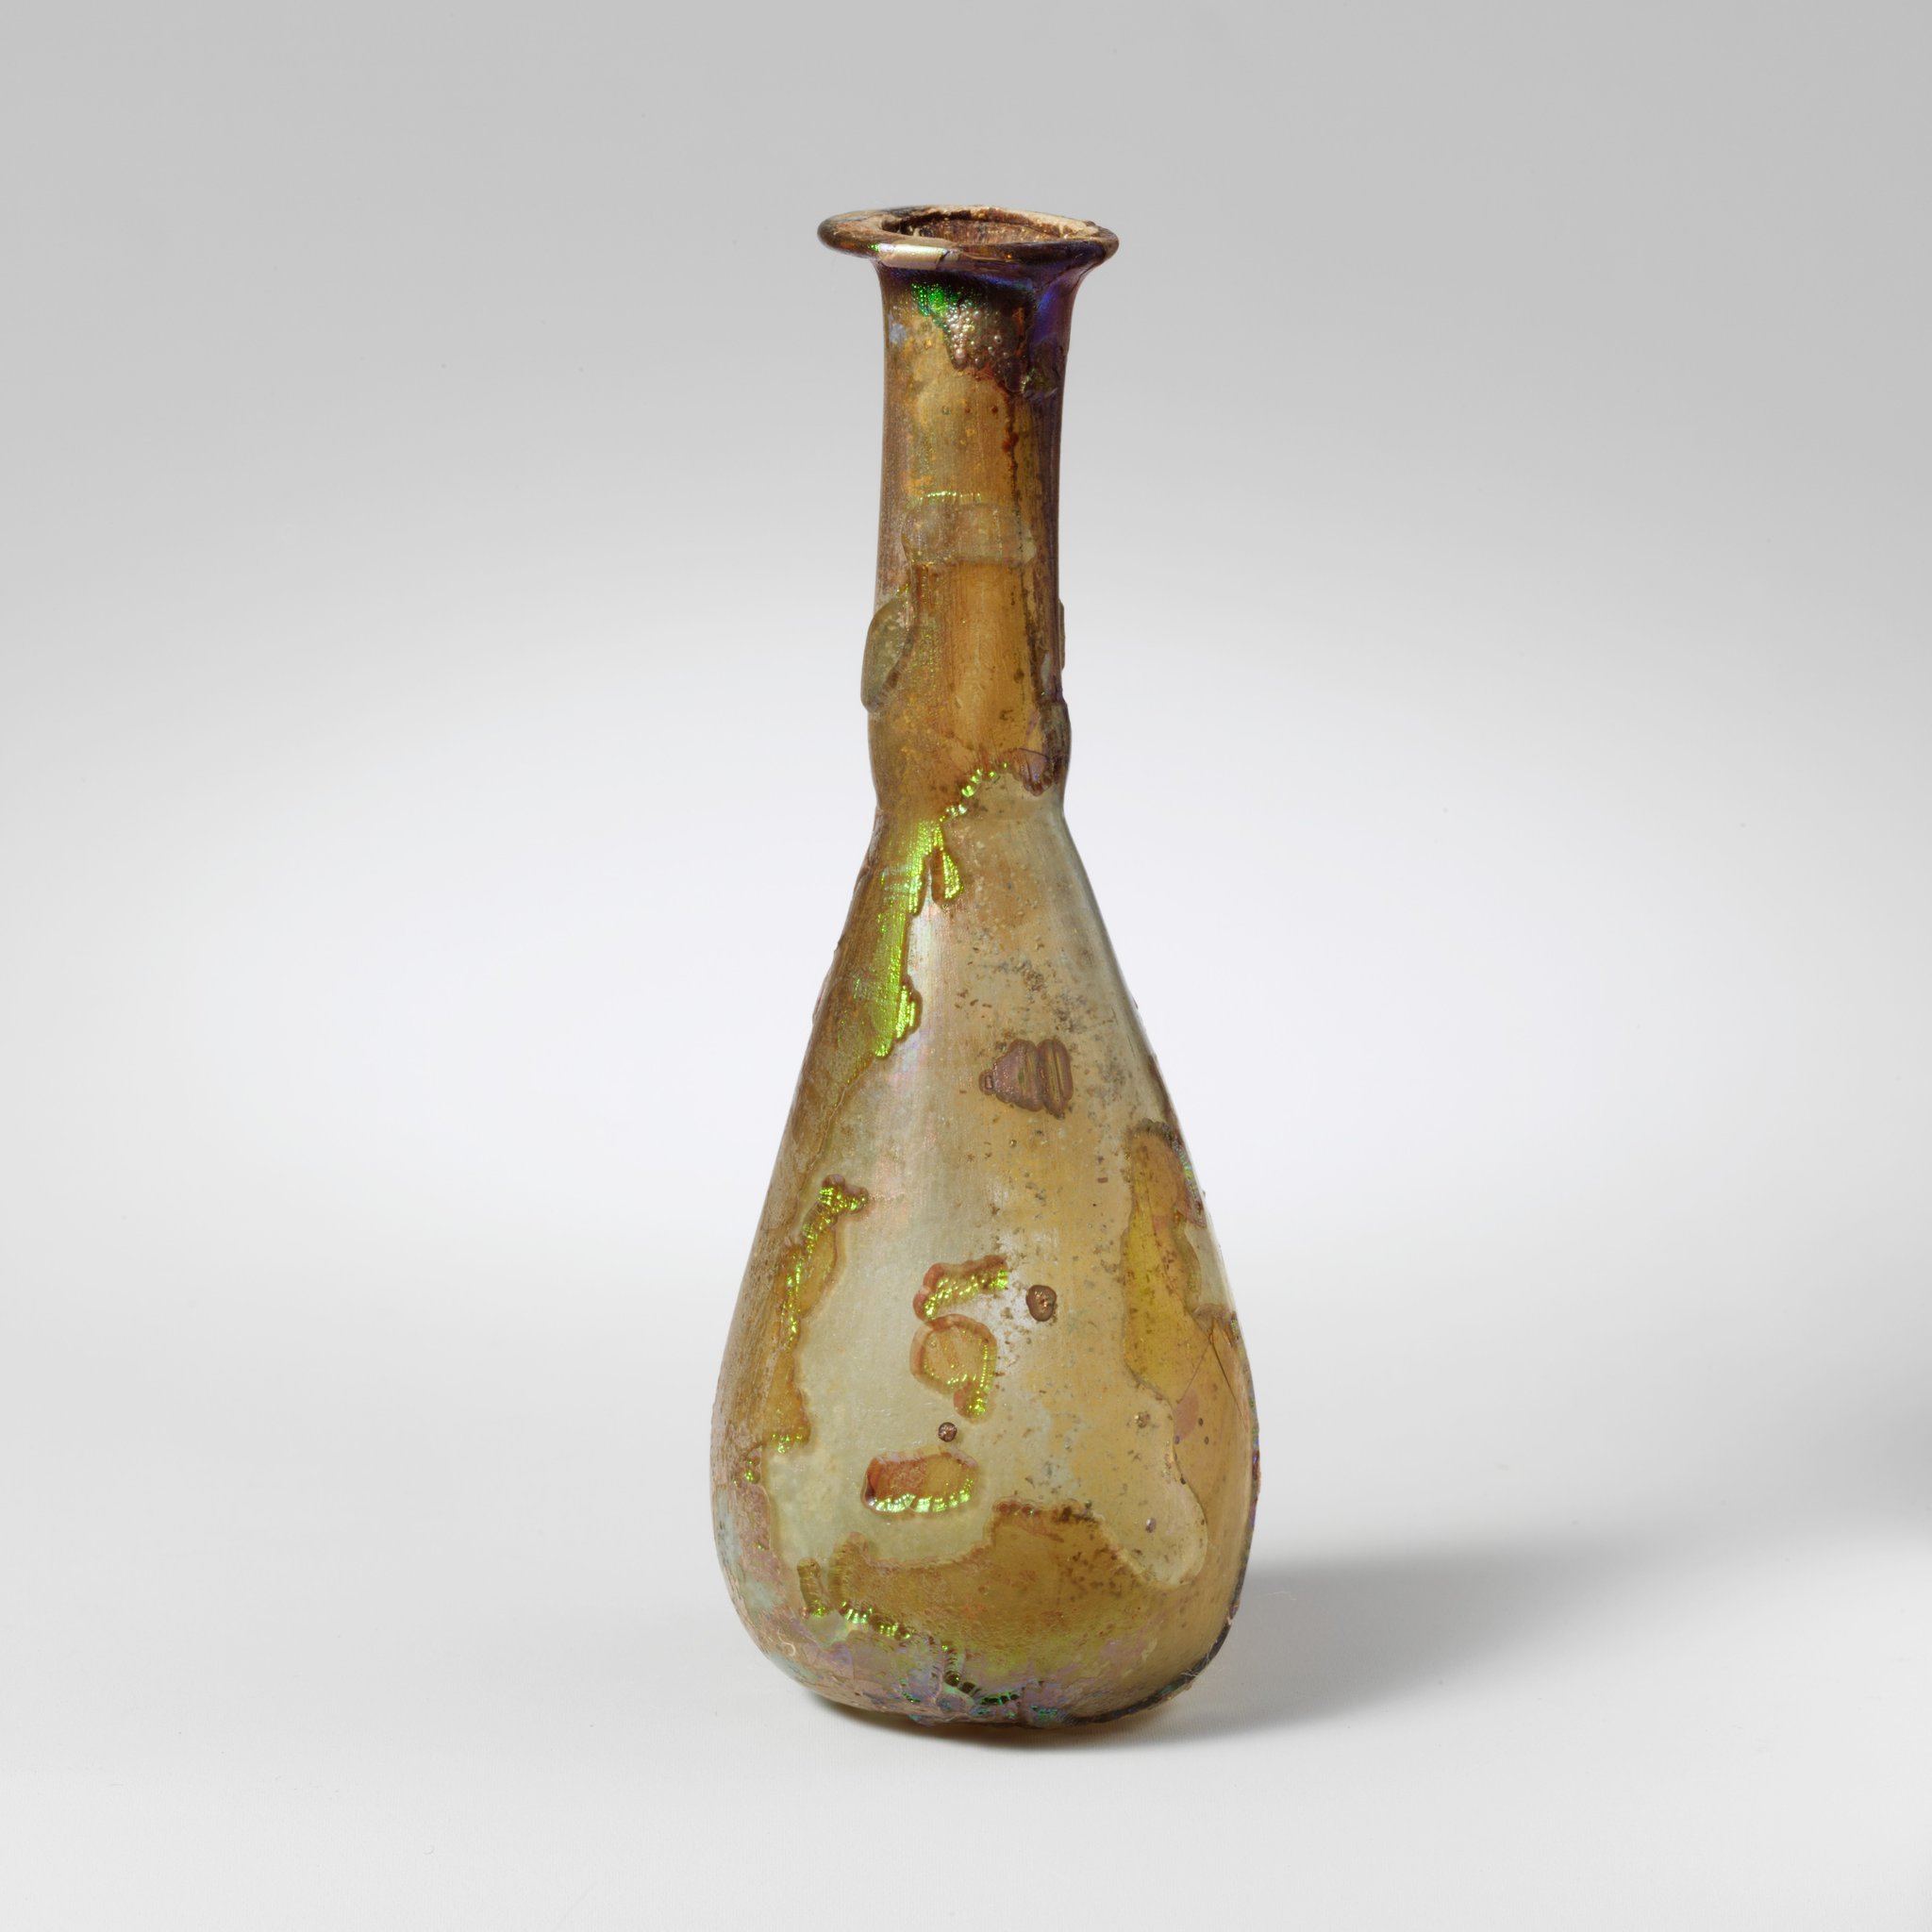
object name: perfume bottle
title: Glass perfume bottle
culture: roman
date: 1-100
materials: glass